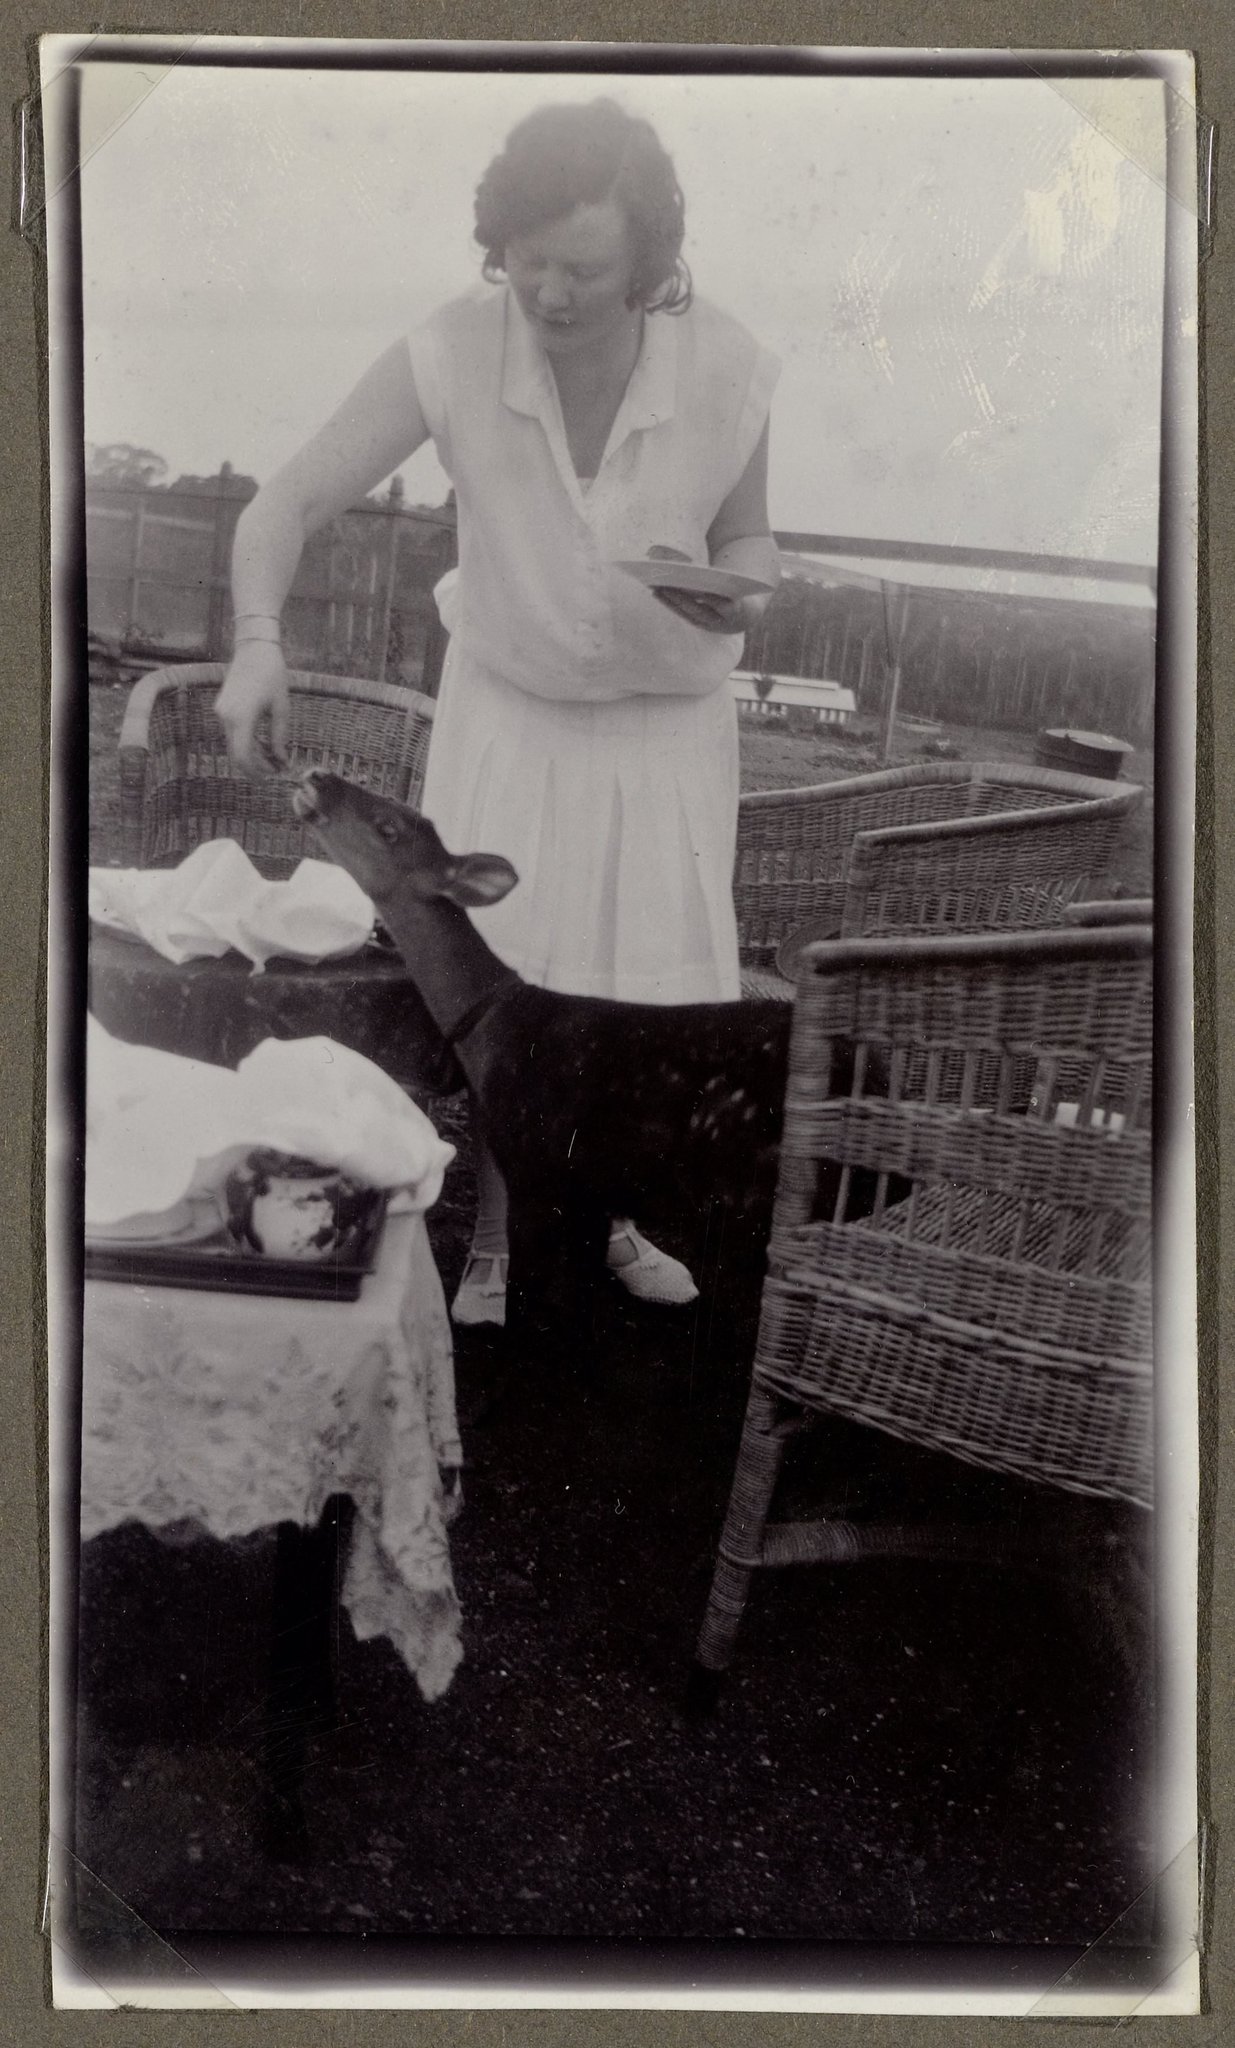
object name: photograph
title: Edith Jetten voert een hertje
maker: Anonymous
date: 1925-1927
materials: photographic support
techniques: photography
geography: suriname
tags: feeding wild animals, suriname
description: Edith Jetten voert een hertje. Foto met hoekjes bevestigd op een bladzijde van een albumblad in het fotoalbum over de familie Jetten en het leven en werken in de mijnstad Moengo in Suriname rond 1927.